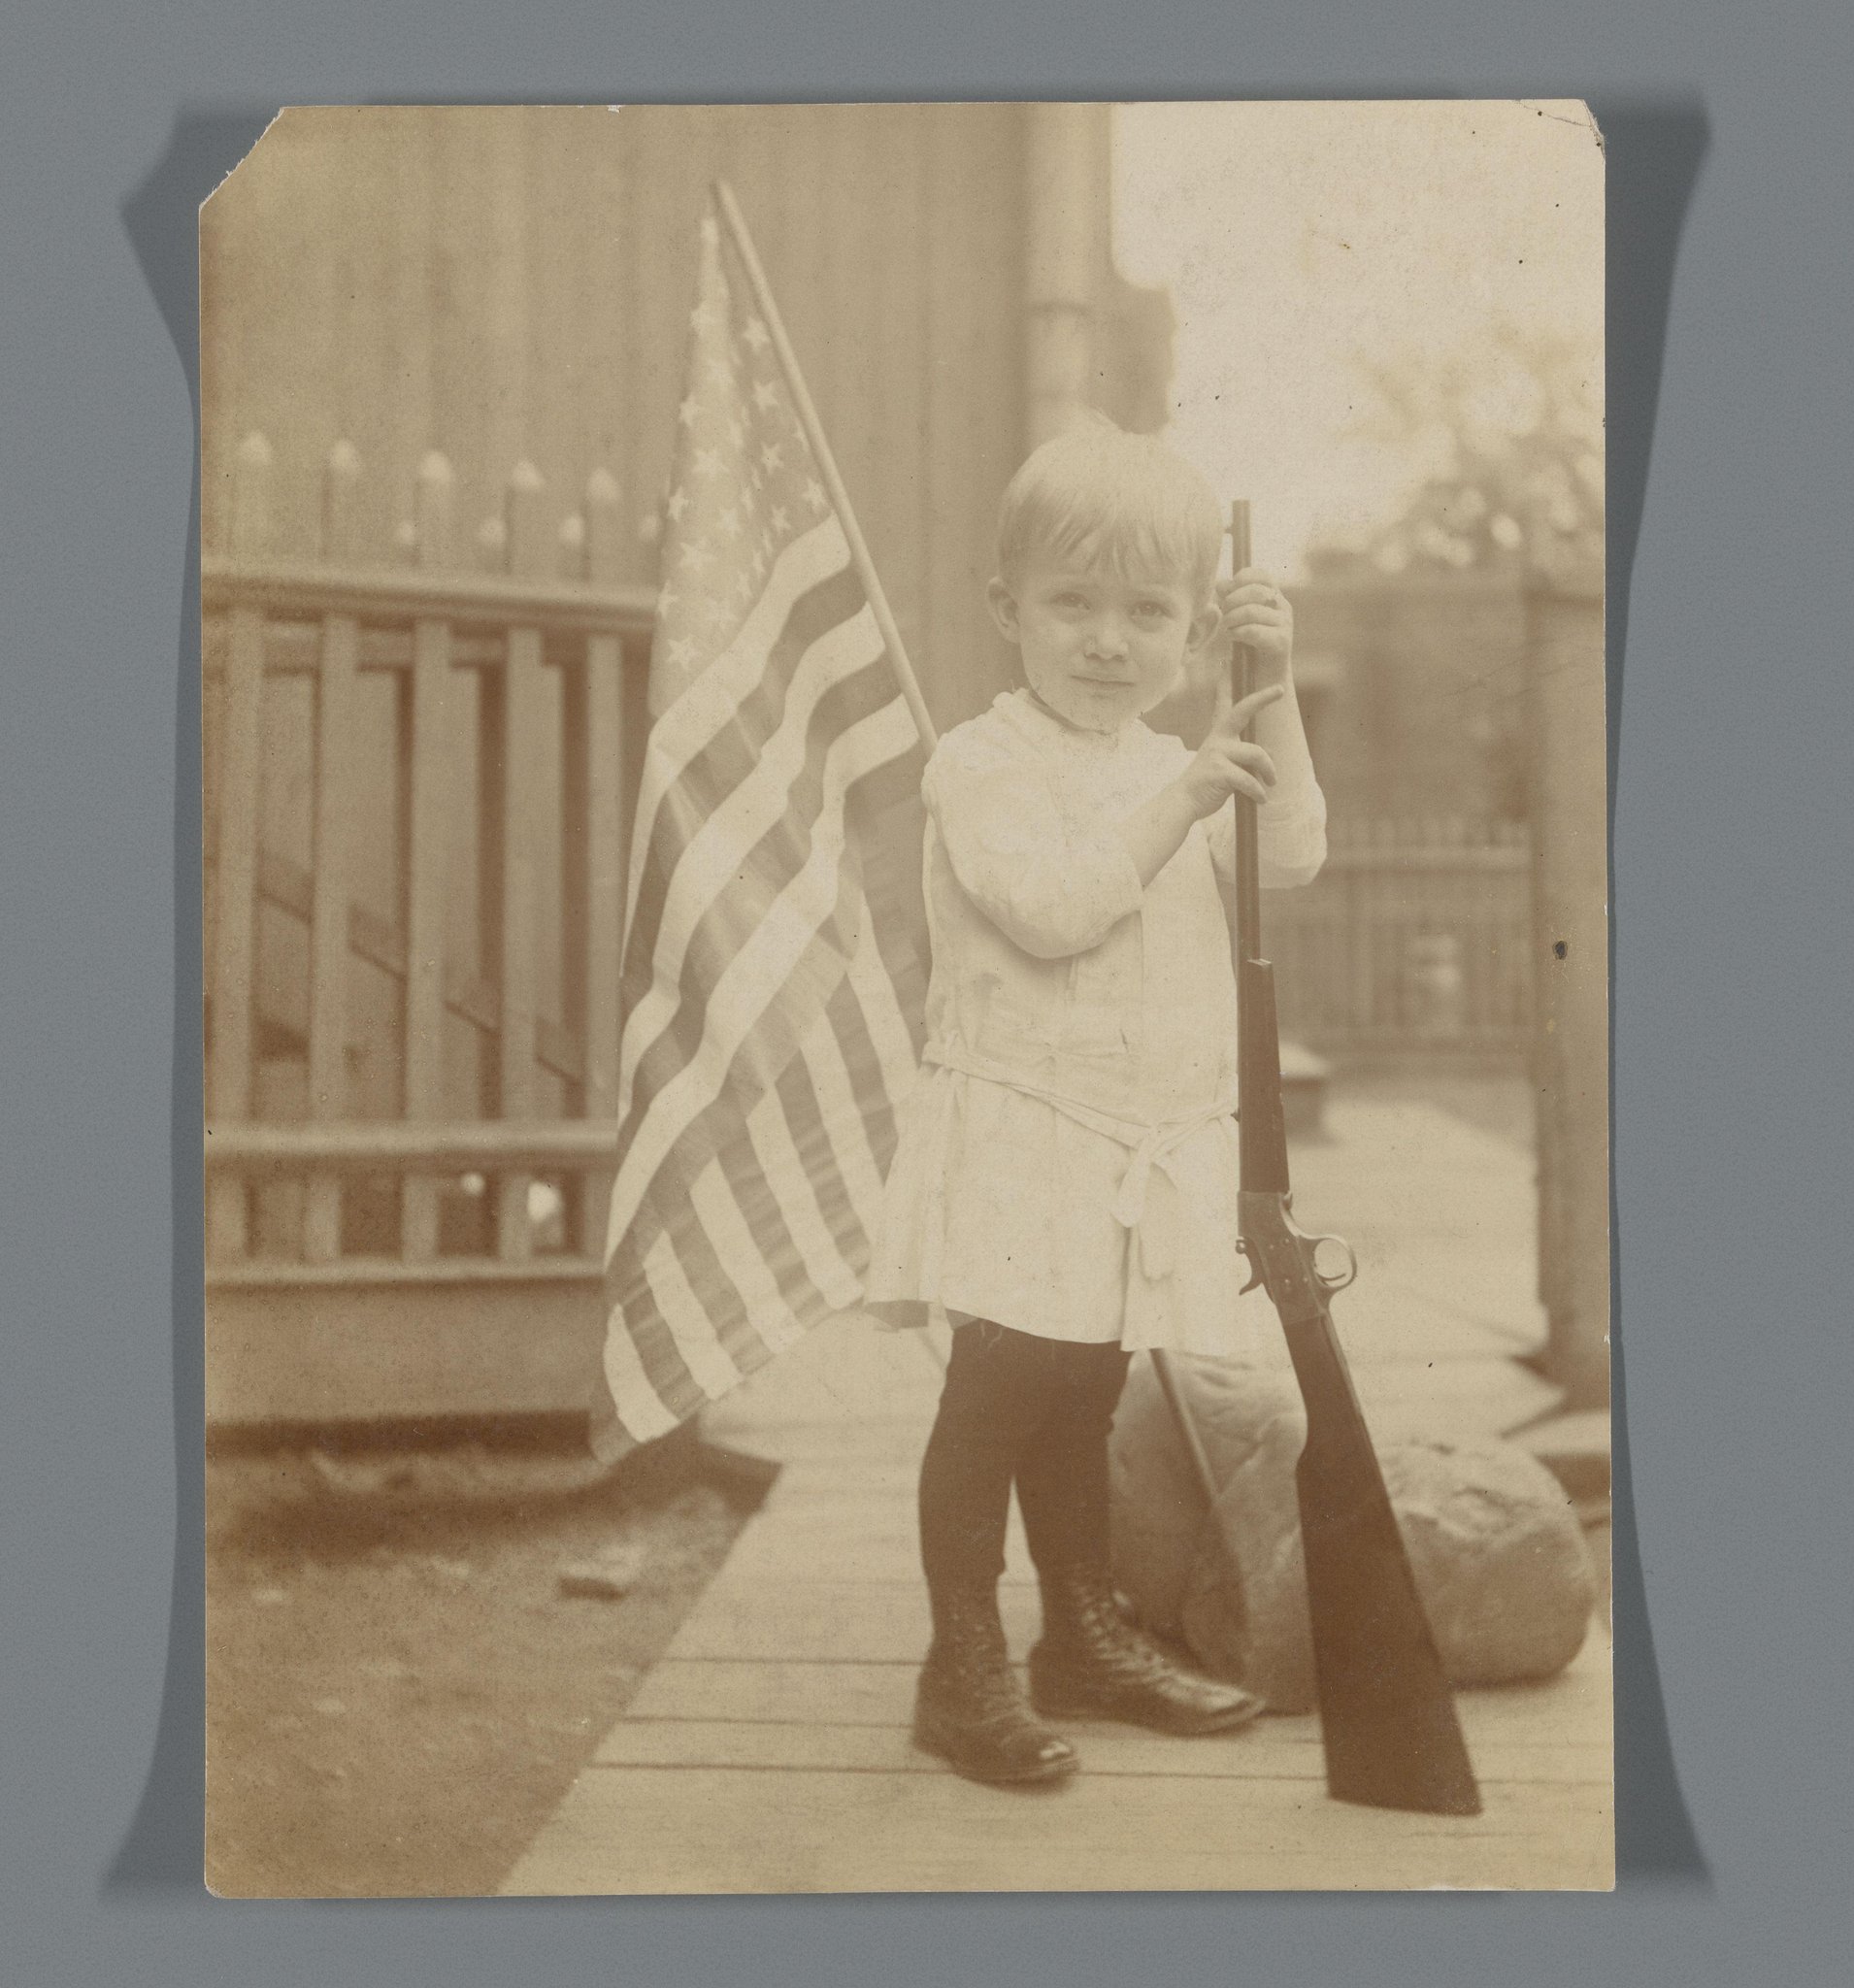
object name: photograph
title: Jongetje met geweer en Amerikaanse vlag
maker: Anonymous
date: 1890-1910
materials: paper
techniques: daylight paper print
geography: united states